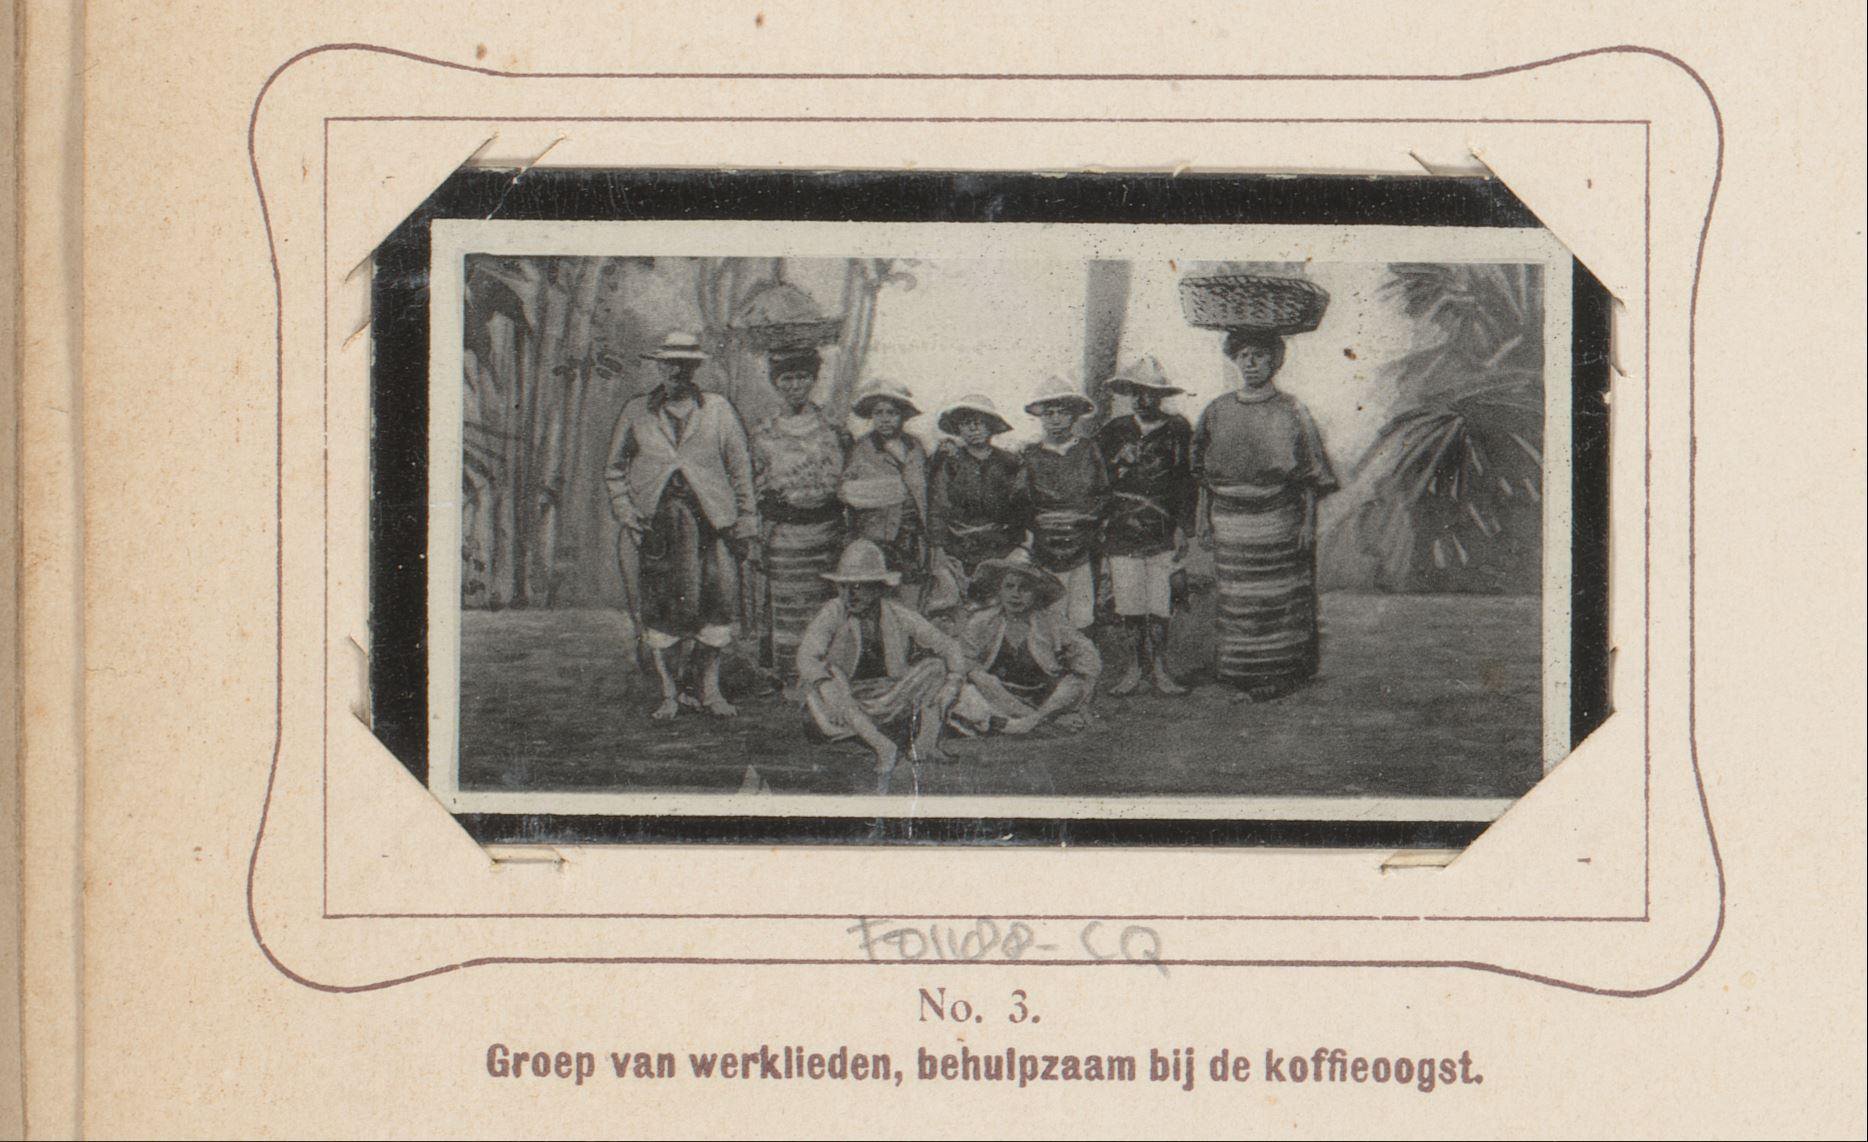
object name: album leaf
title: Groepsportret van arbeiders op de koffieplantage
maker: Anonymous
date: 1906-1907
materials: paper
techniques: photograph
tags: coffee, plantation (+ landscape (in the non-temperate zone) with figures, staffage), anonymous historical persons portrayed in a group, in a group-portrait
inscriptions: inscription: ‘No. 3./ Groep van werklieden, behulpzaam bij de koffieoogst.’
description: Deze prent maakt deel uit van een album.